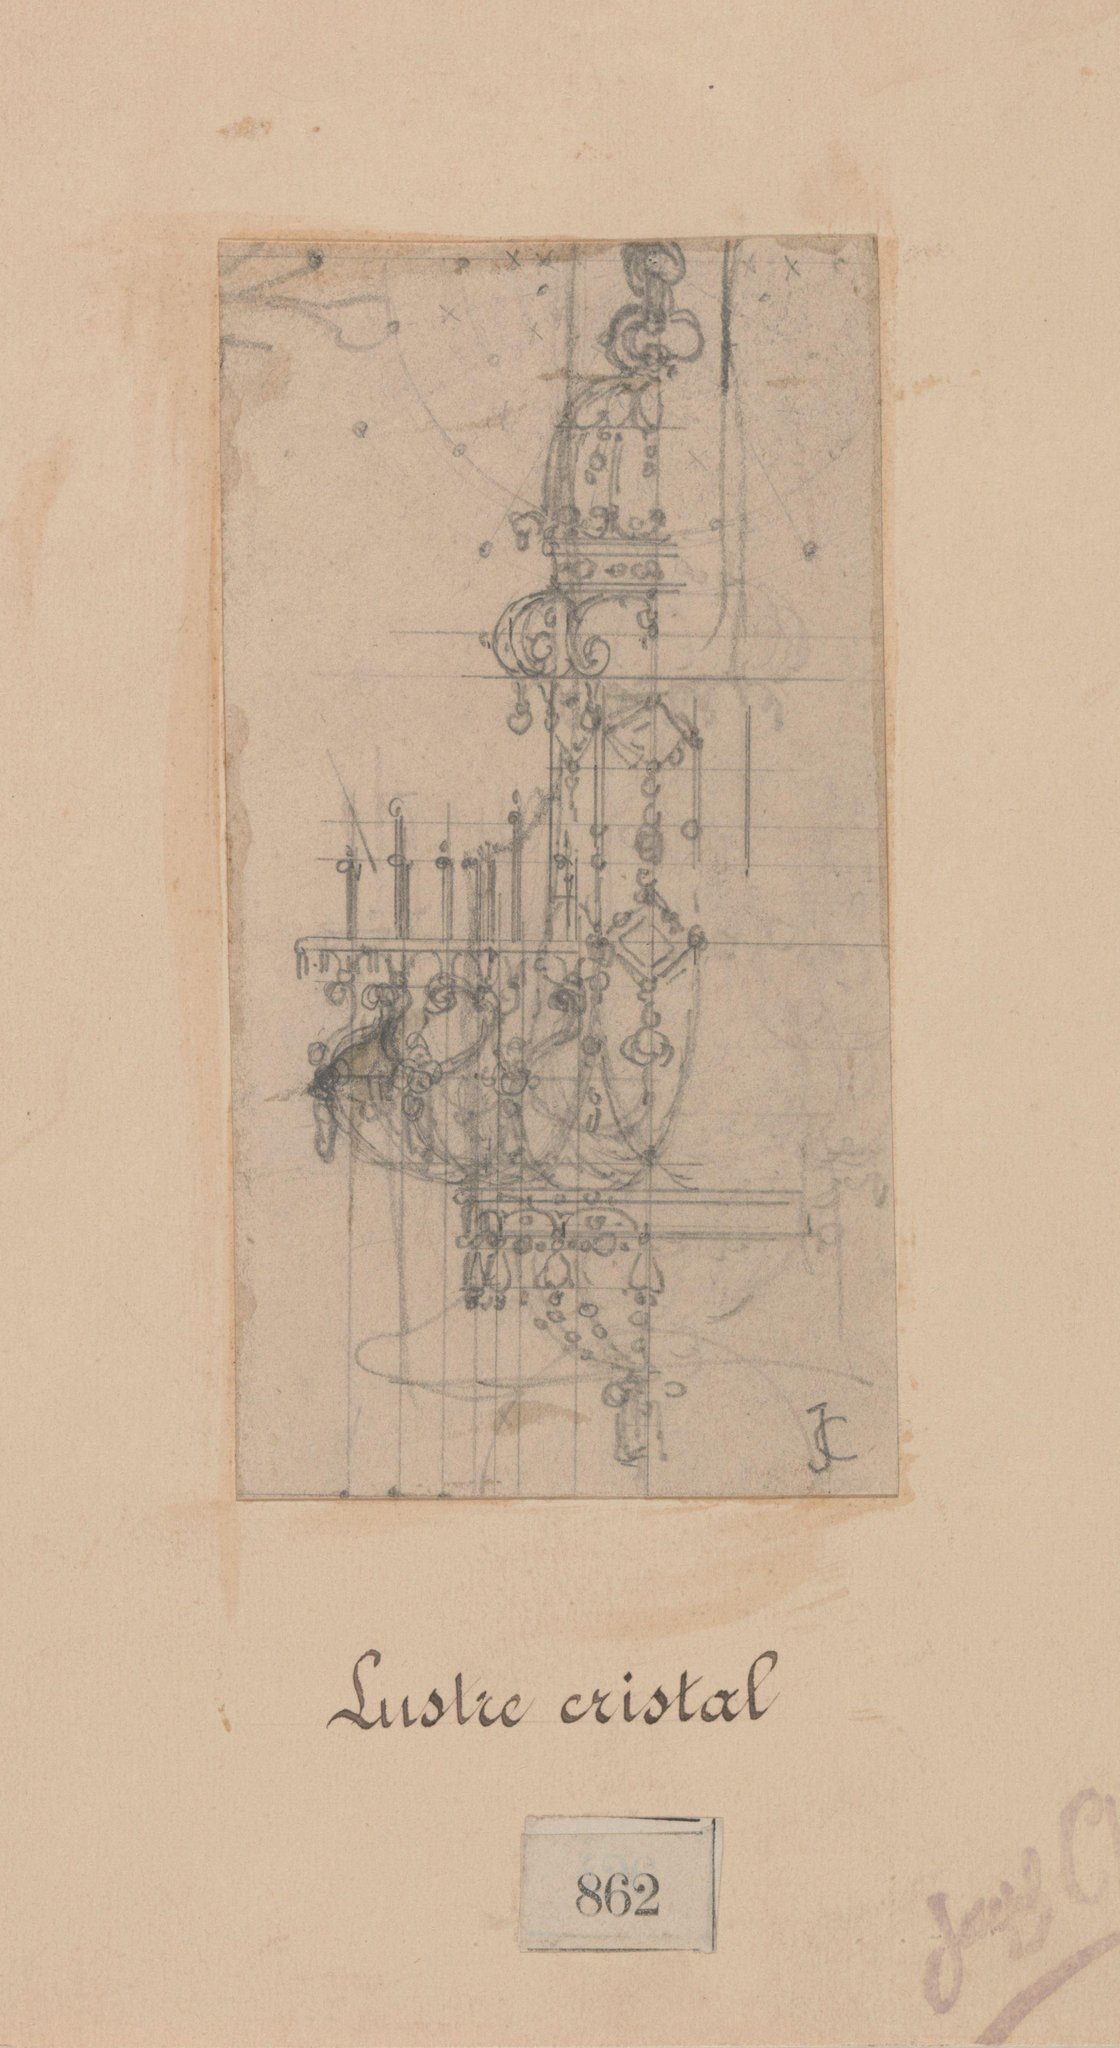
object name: design drawing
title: Kroonluchter (linkerhelft uitgewerkt)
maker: gustave joseph chéret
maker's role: sculptor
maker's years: 1838-1894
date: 1870-1894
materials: cardboard, graphite, paper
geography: paris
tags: chandelier, candelabrum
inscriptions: monogram: ‘JC’, workshop stamp: ‘Joseph Chéret’, label: ‘862’, inscription: ‘`Lustre cristal’